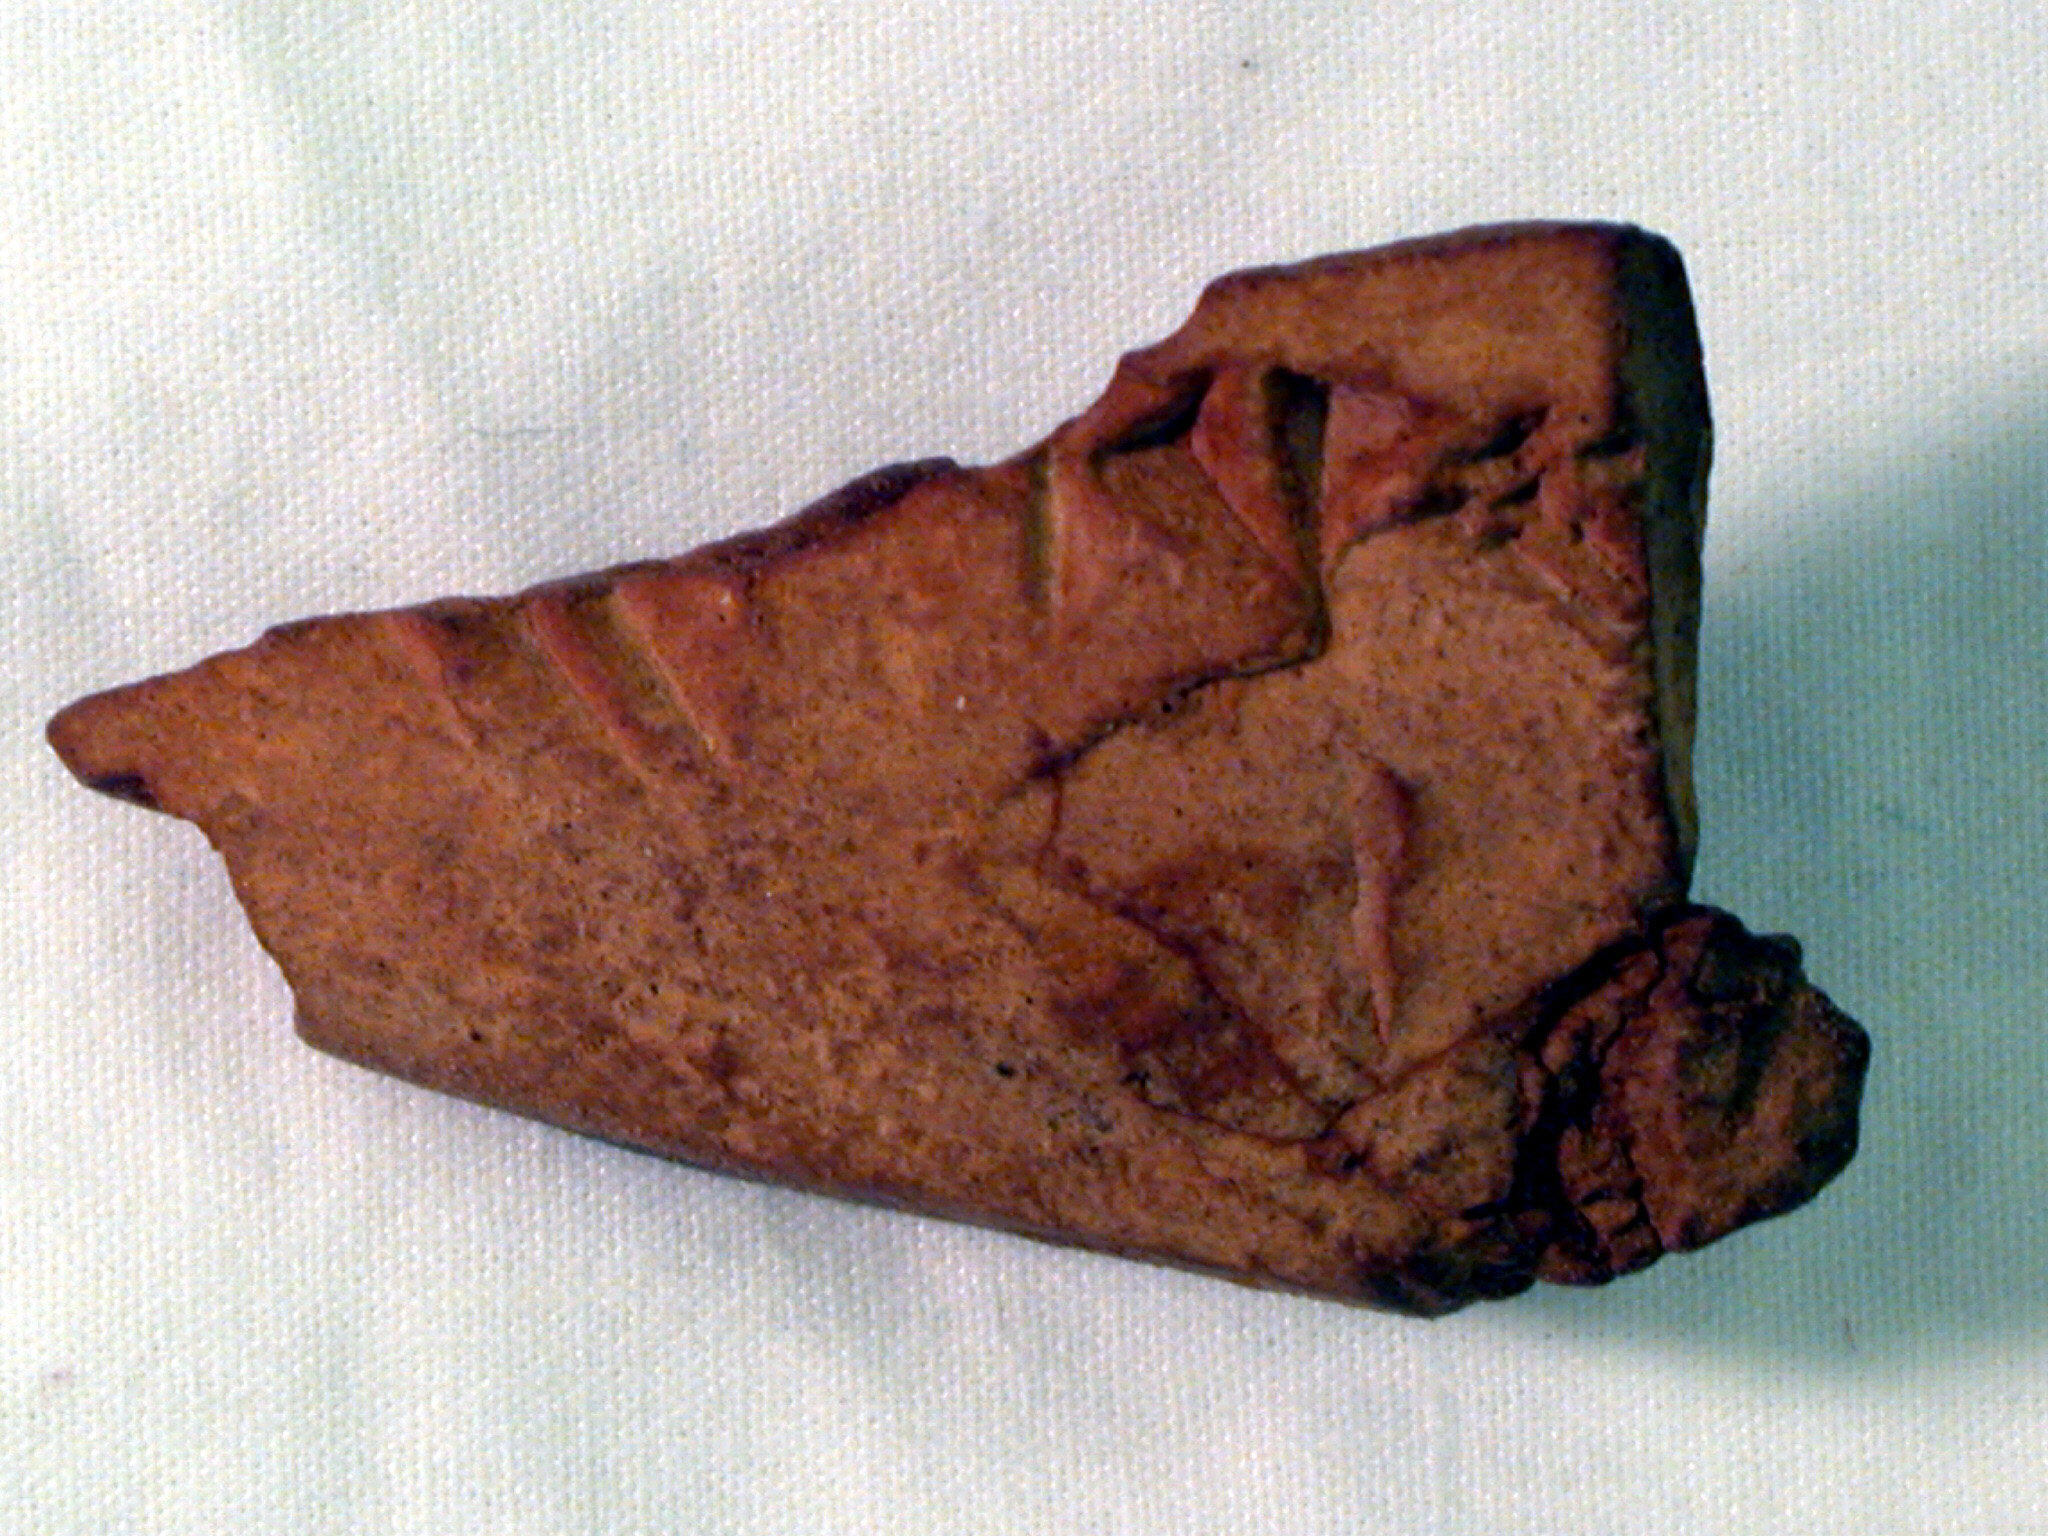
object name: cuneiform tablet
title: Cuneiform tablet: fragment, Ebabbar archive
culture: achaemenid or babylonian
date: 700-301 BCE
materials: clay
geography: mesopotamia